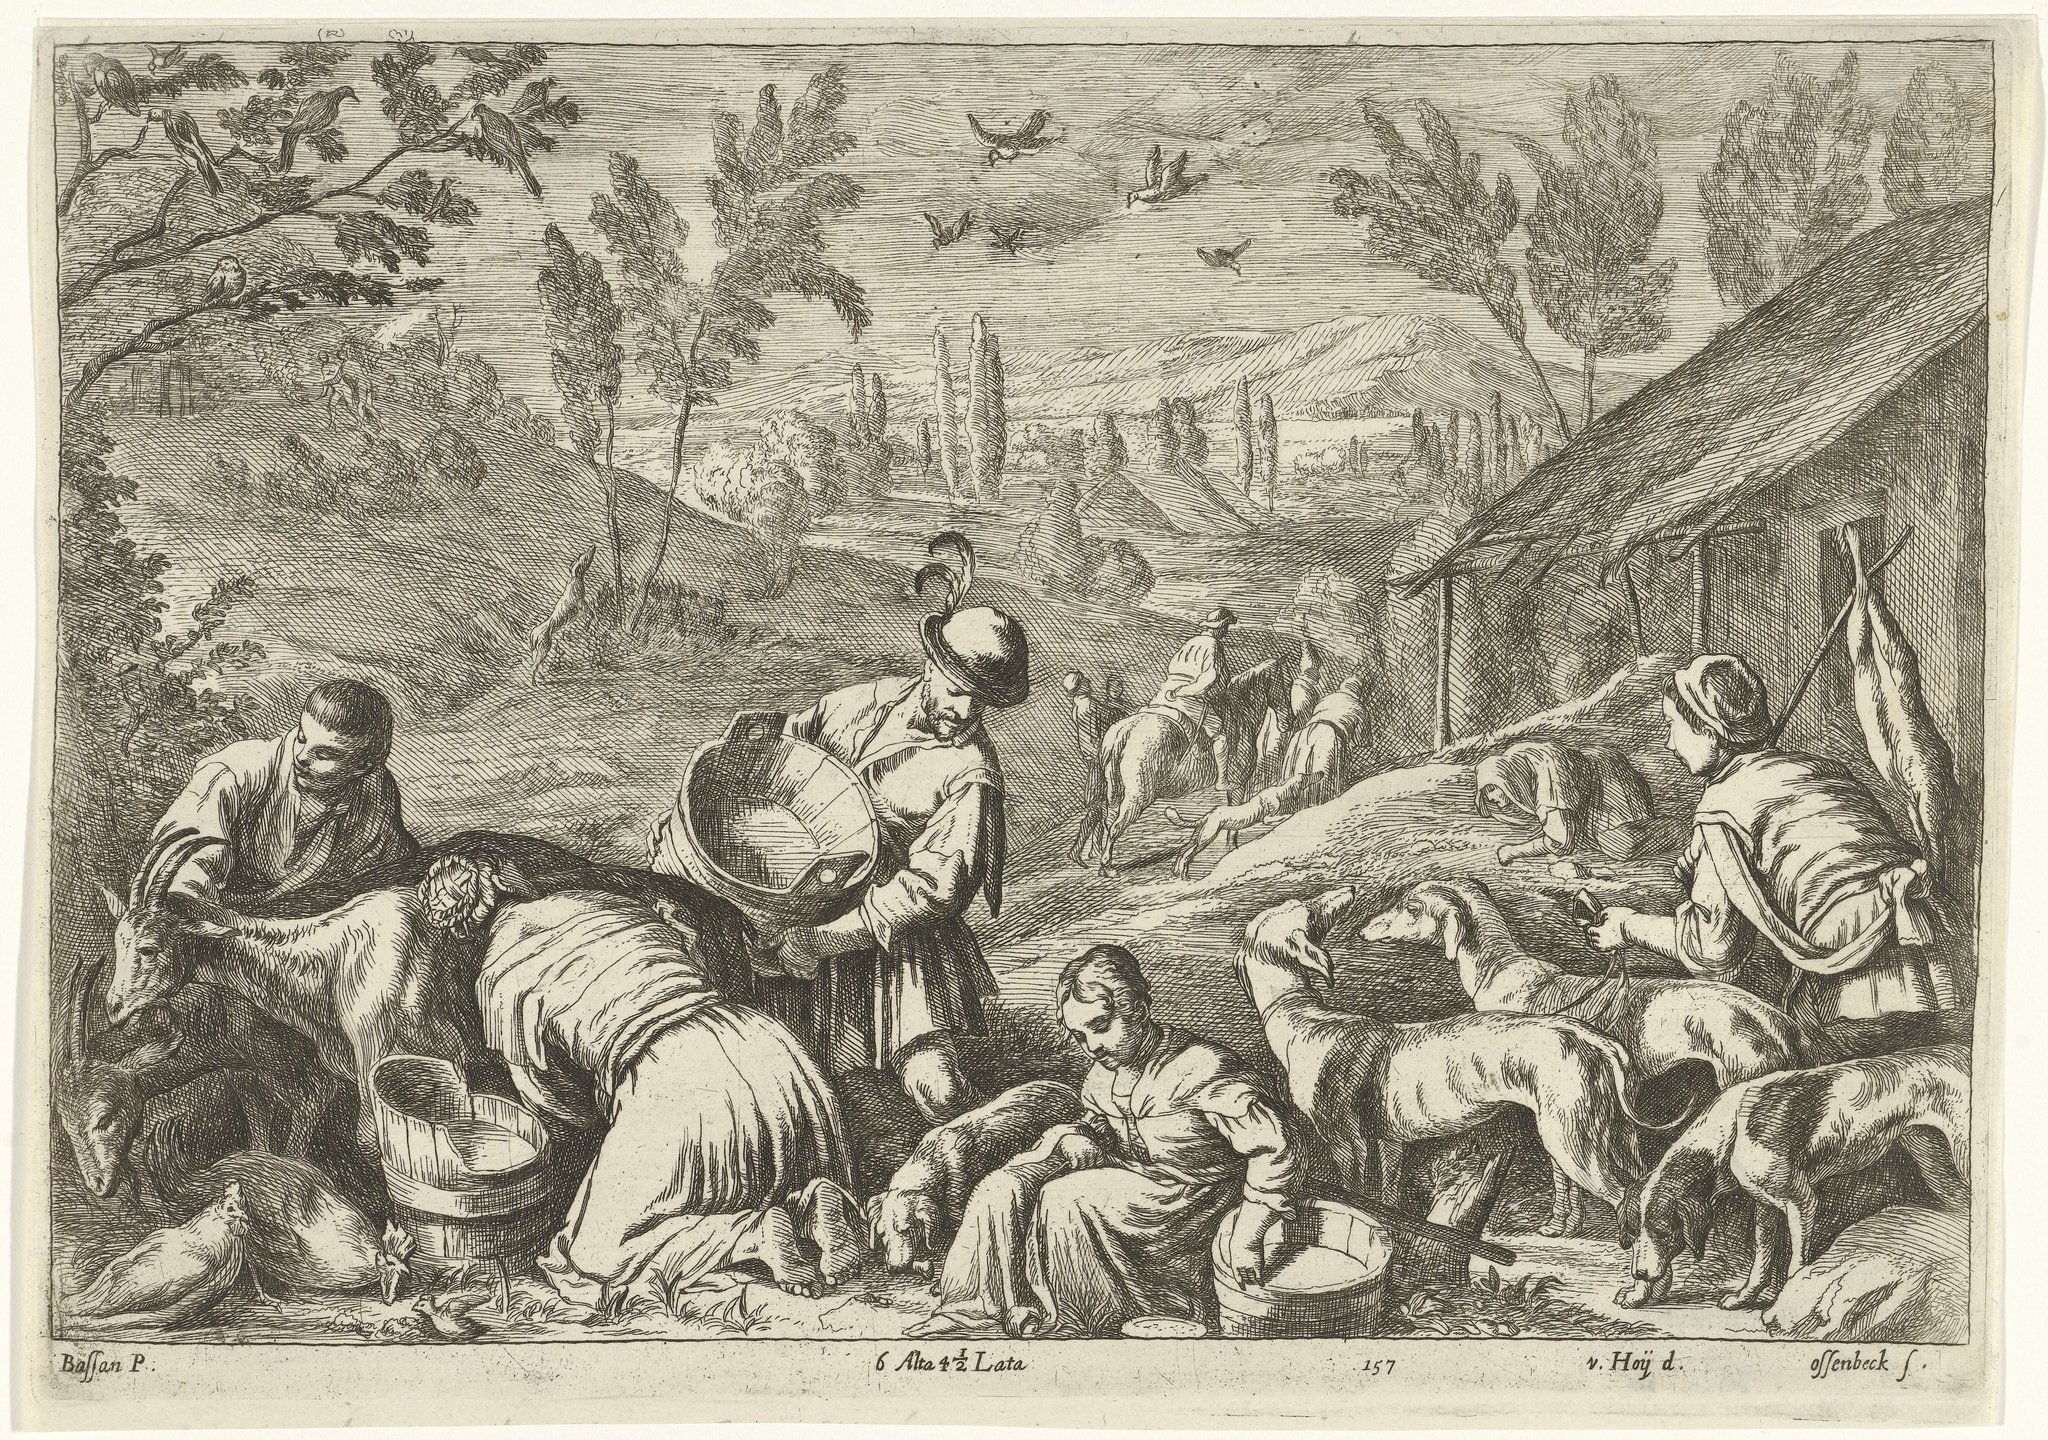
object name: print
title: De vier seizoenen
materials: paper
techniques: engraving, etching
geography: brussels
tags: spring landscape; landscape symbolizing spring (the four seasons of the year)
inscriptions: number: ‘No. 741’, collector's mark: Lugt 2610, collector's mark: Lugt 2228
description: Een groepje boeren aan het werk buiten hun huis. Een vrouw melkt de geiten. Een man draagt een tobbe met melk. Rechts een jongen met zijn honden, hij draagt een dode haas op zijn schouder. Voorstelling van de lente in een serie met prenten van de vier seizoenen.